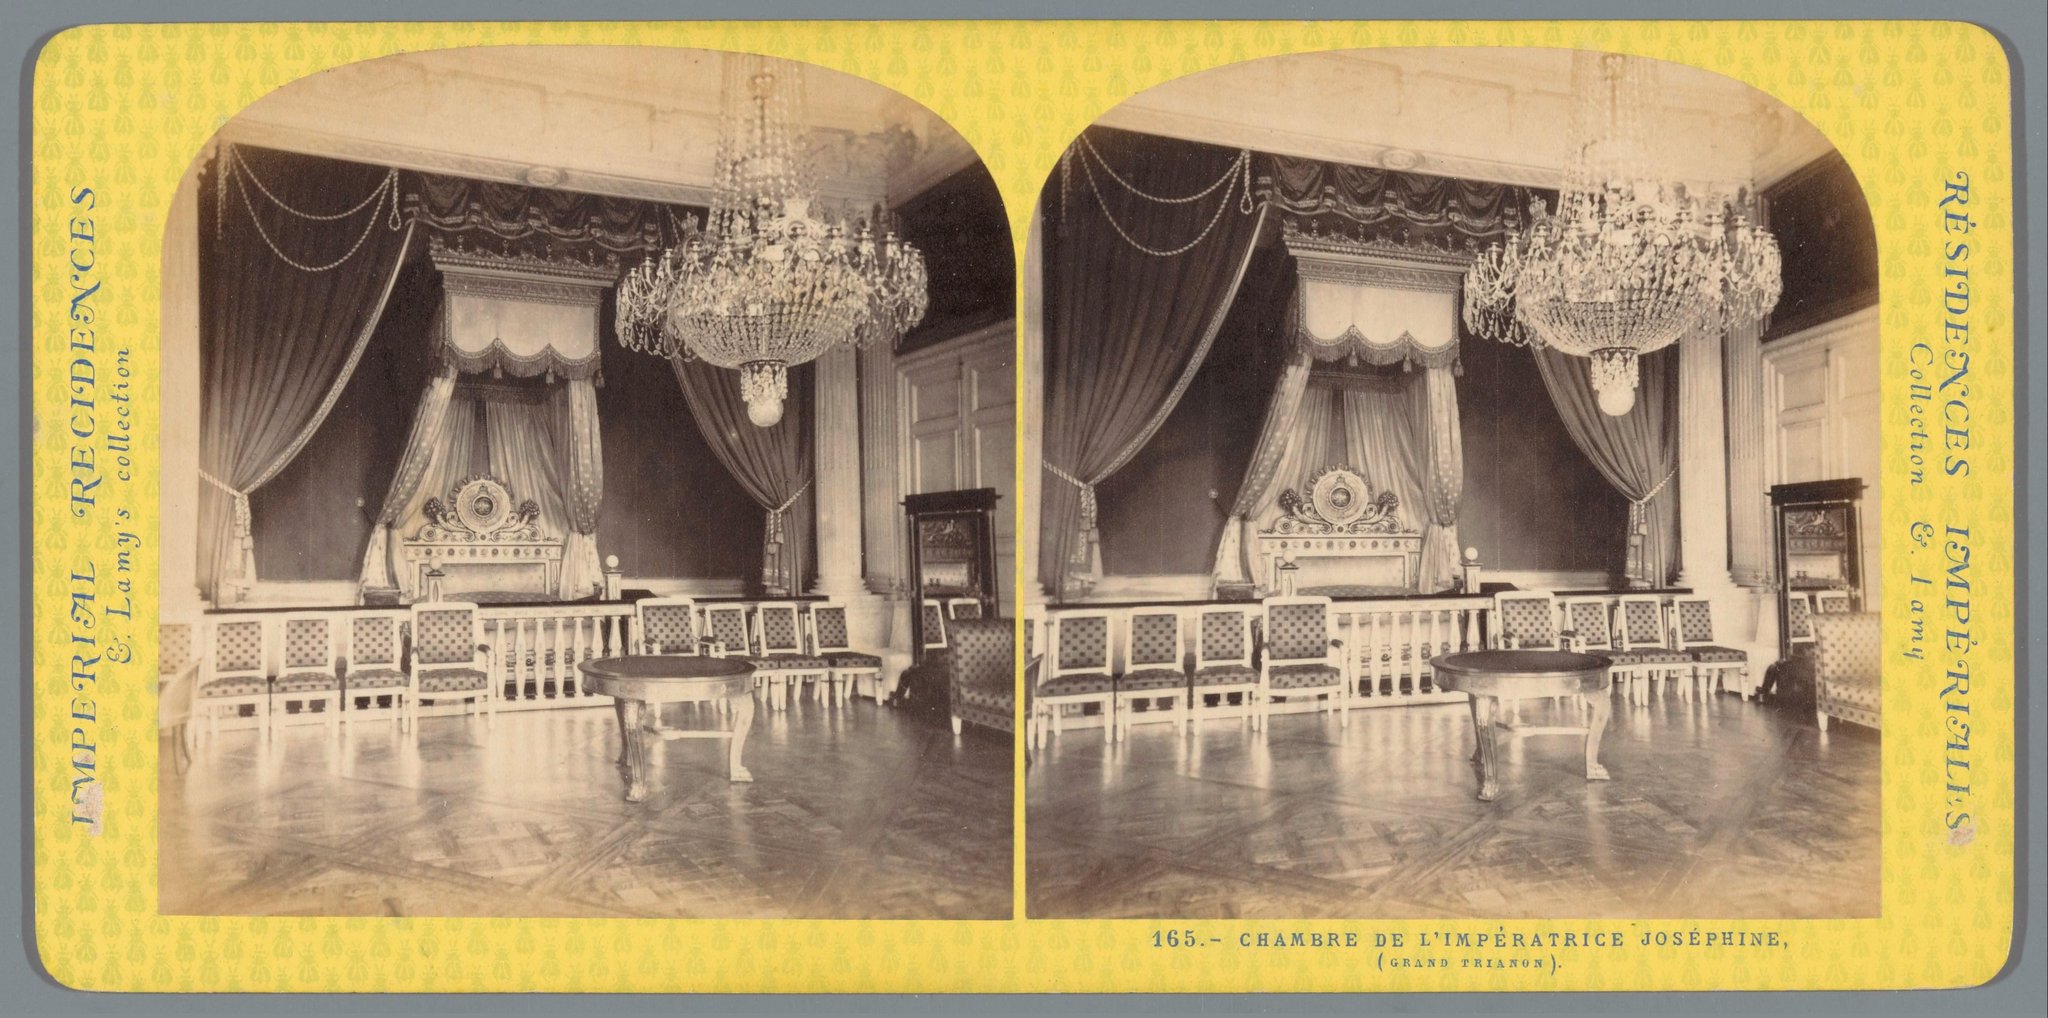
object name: stereograph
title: Chambre de l'Imperatrice Josephine, (Grand Trianon)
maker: ernest eléonor pierre lamy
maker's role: publisher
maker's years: 1828-1900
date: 1860-1880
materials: cardboard, photographic support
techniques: albumen print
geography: grand trianon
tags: chandelier, candelabrum, bed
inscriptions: inscription: ‘E. Lamy's collection’, number: ‘165.’